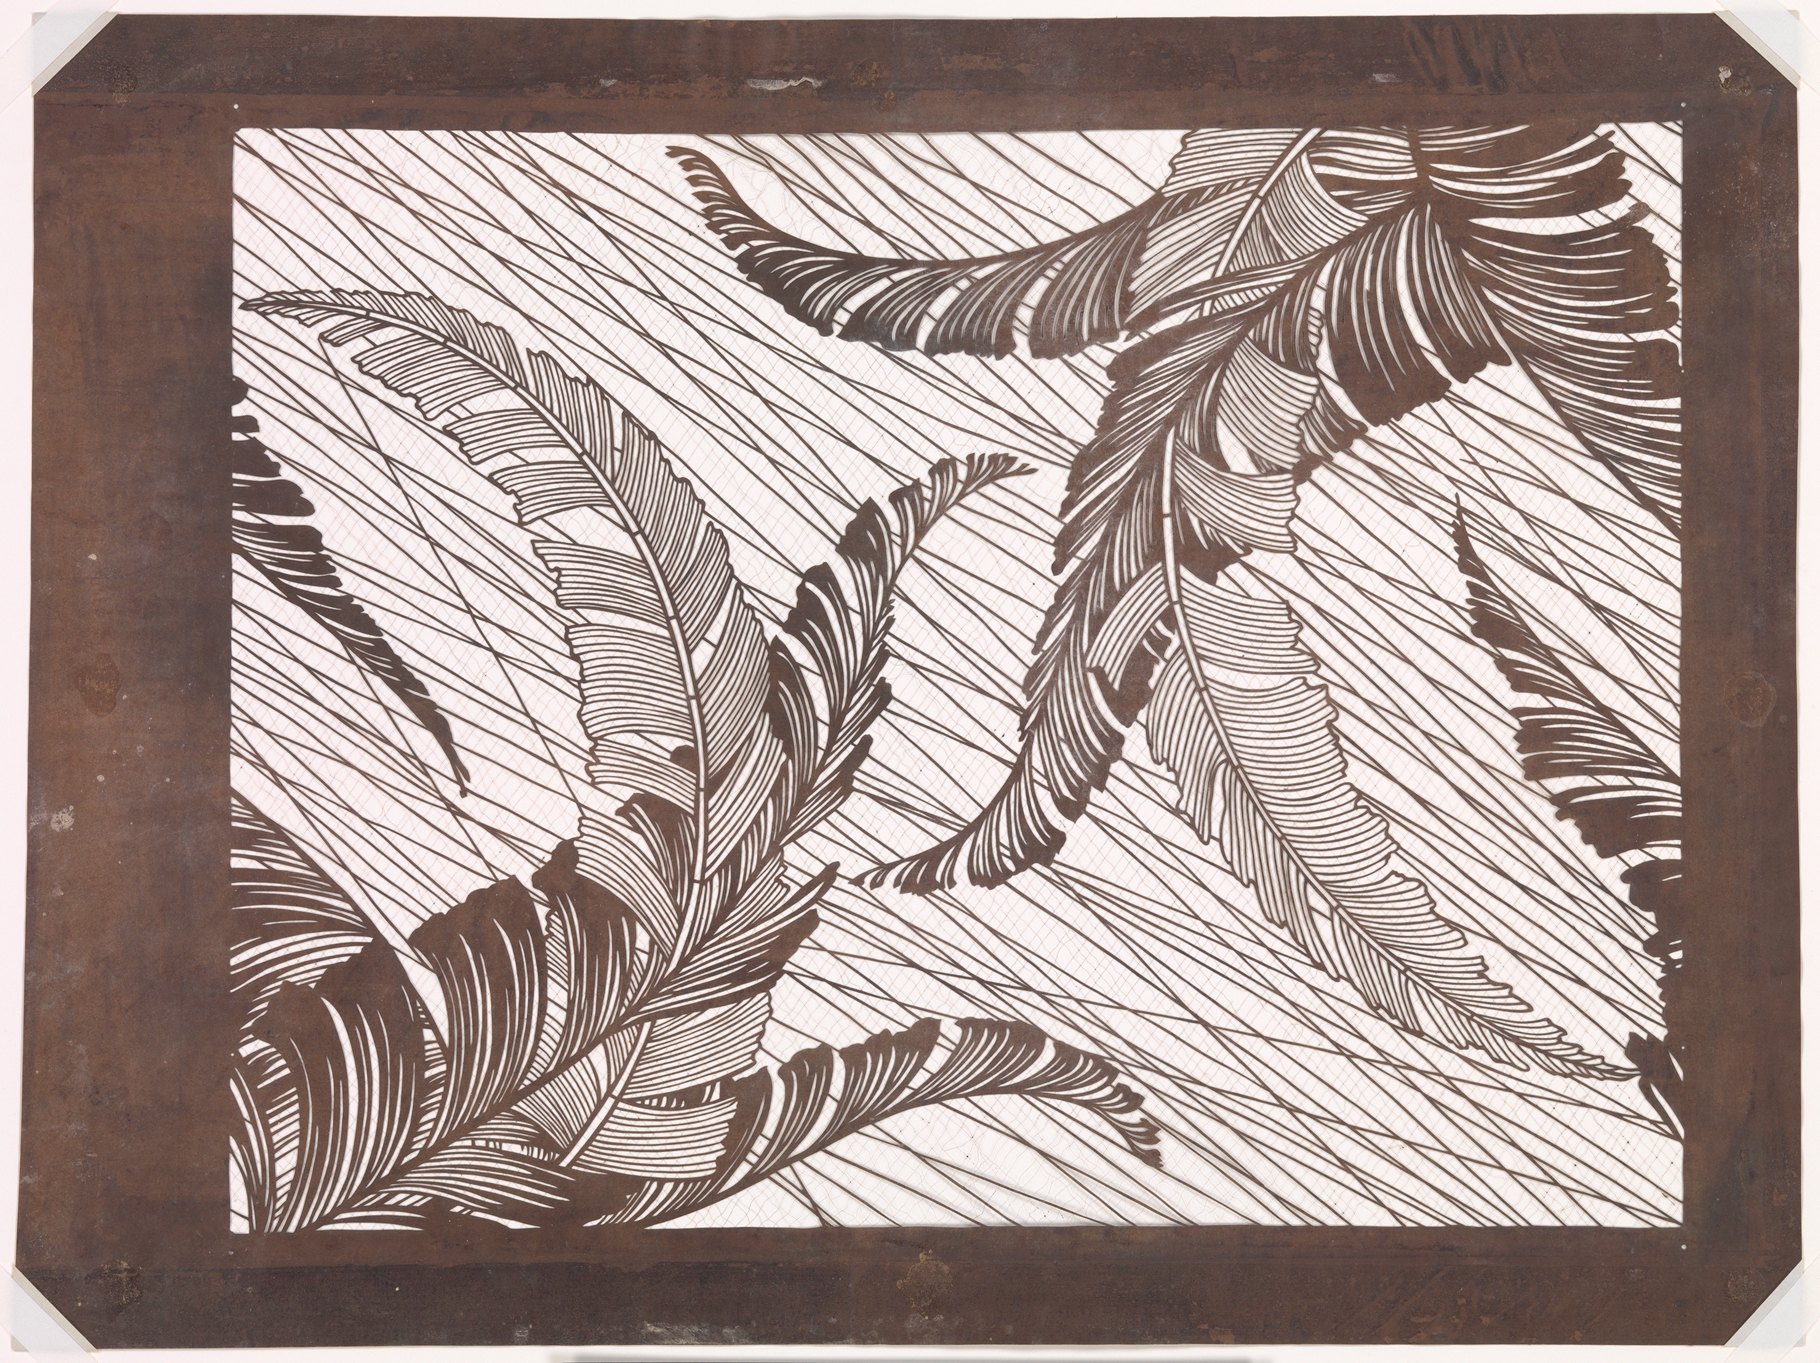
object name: stencil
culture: japanese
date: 1801-1900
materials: paper, silk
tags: leaves